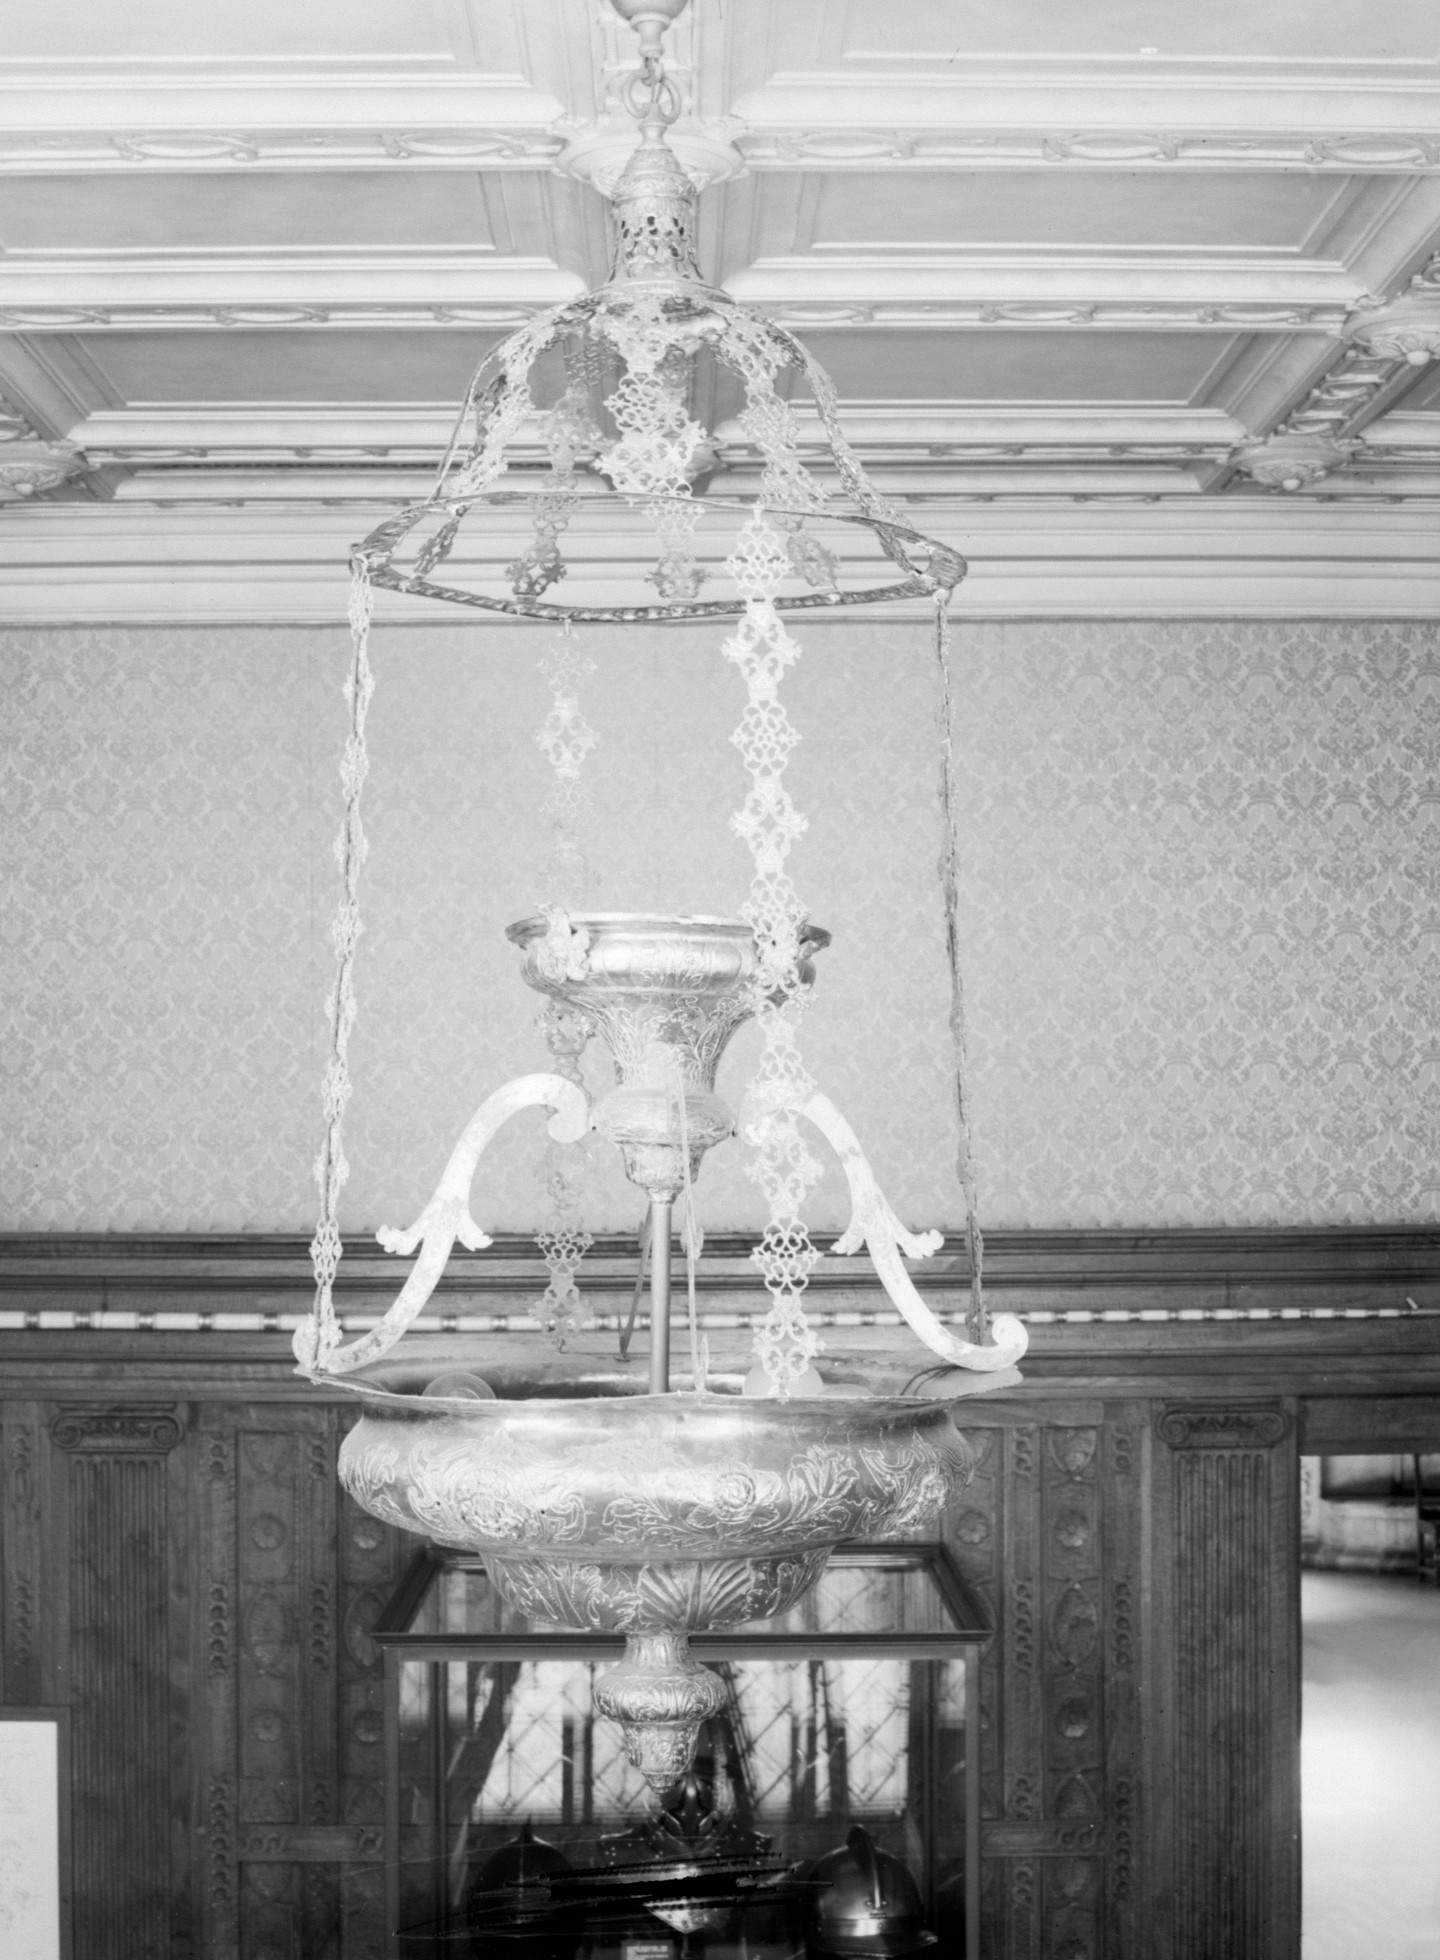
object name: sanctuary lamp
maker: juan antonio dominguez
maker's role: maker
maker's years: 1702-1739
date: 1701-1750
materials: silver